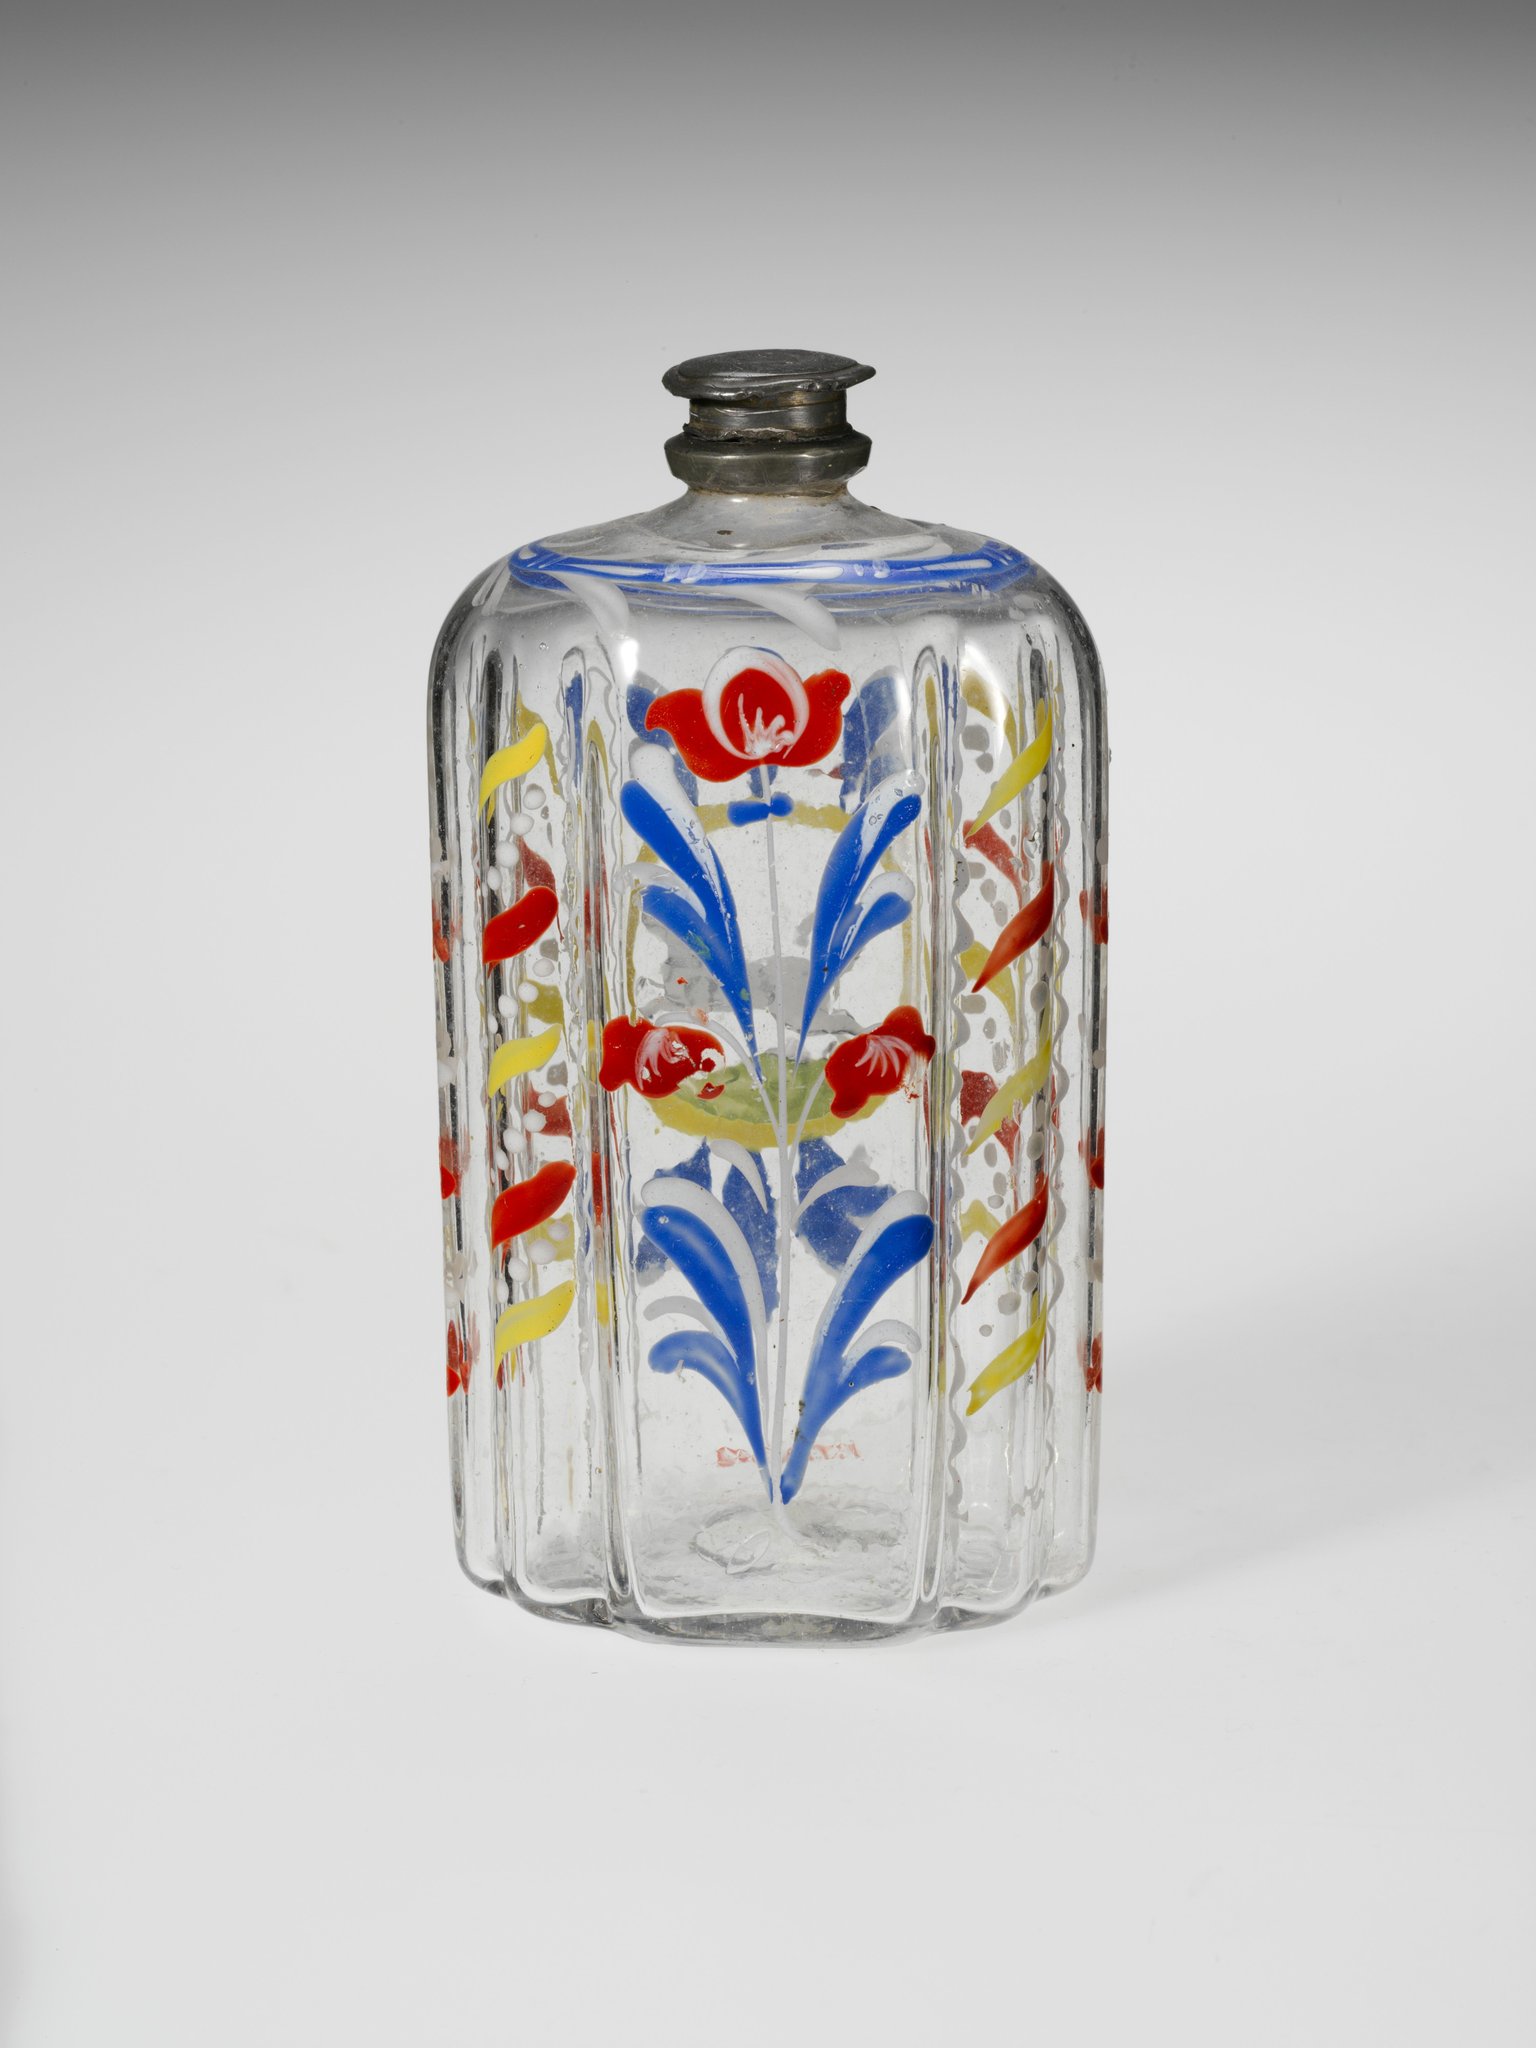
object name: bottle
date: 1763-1779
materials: enamel, glass, lead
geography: czech republic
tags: flowers